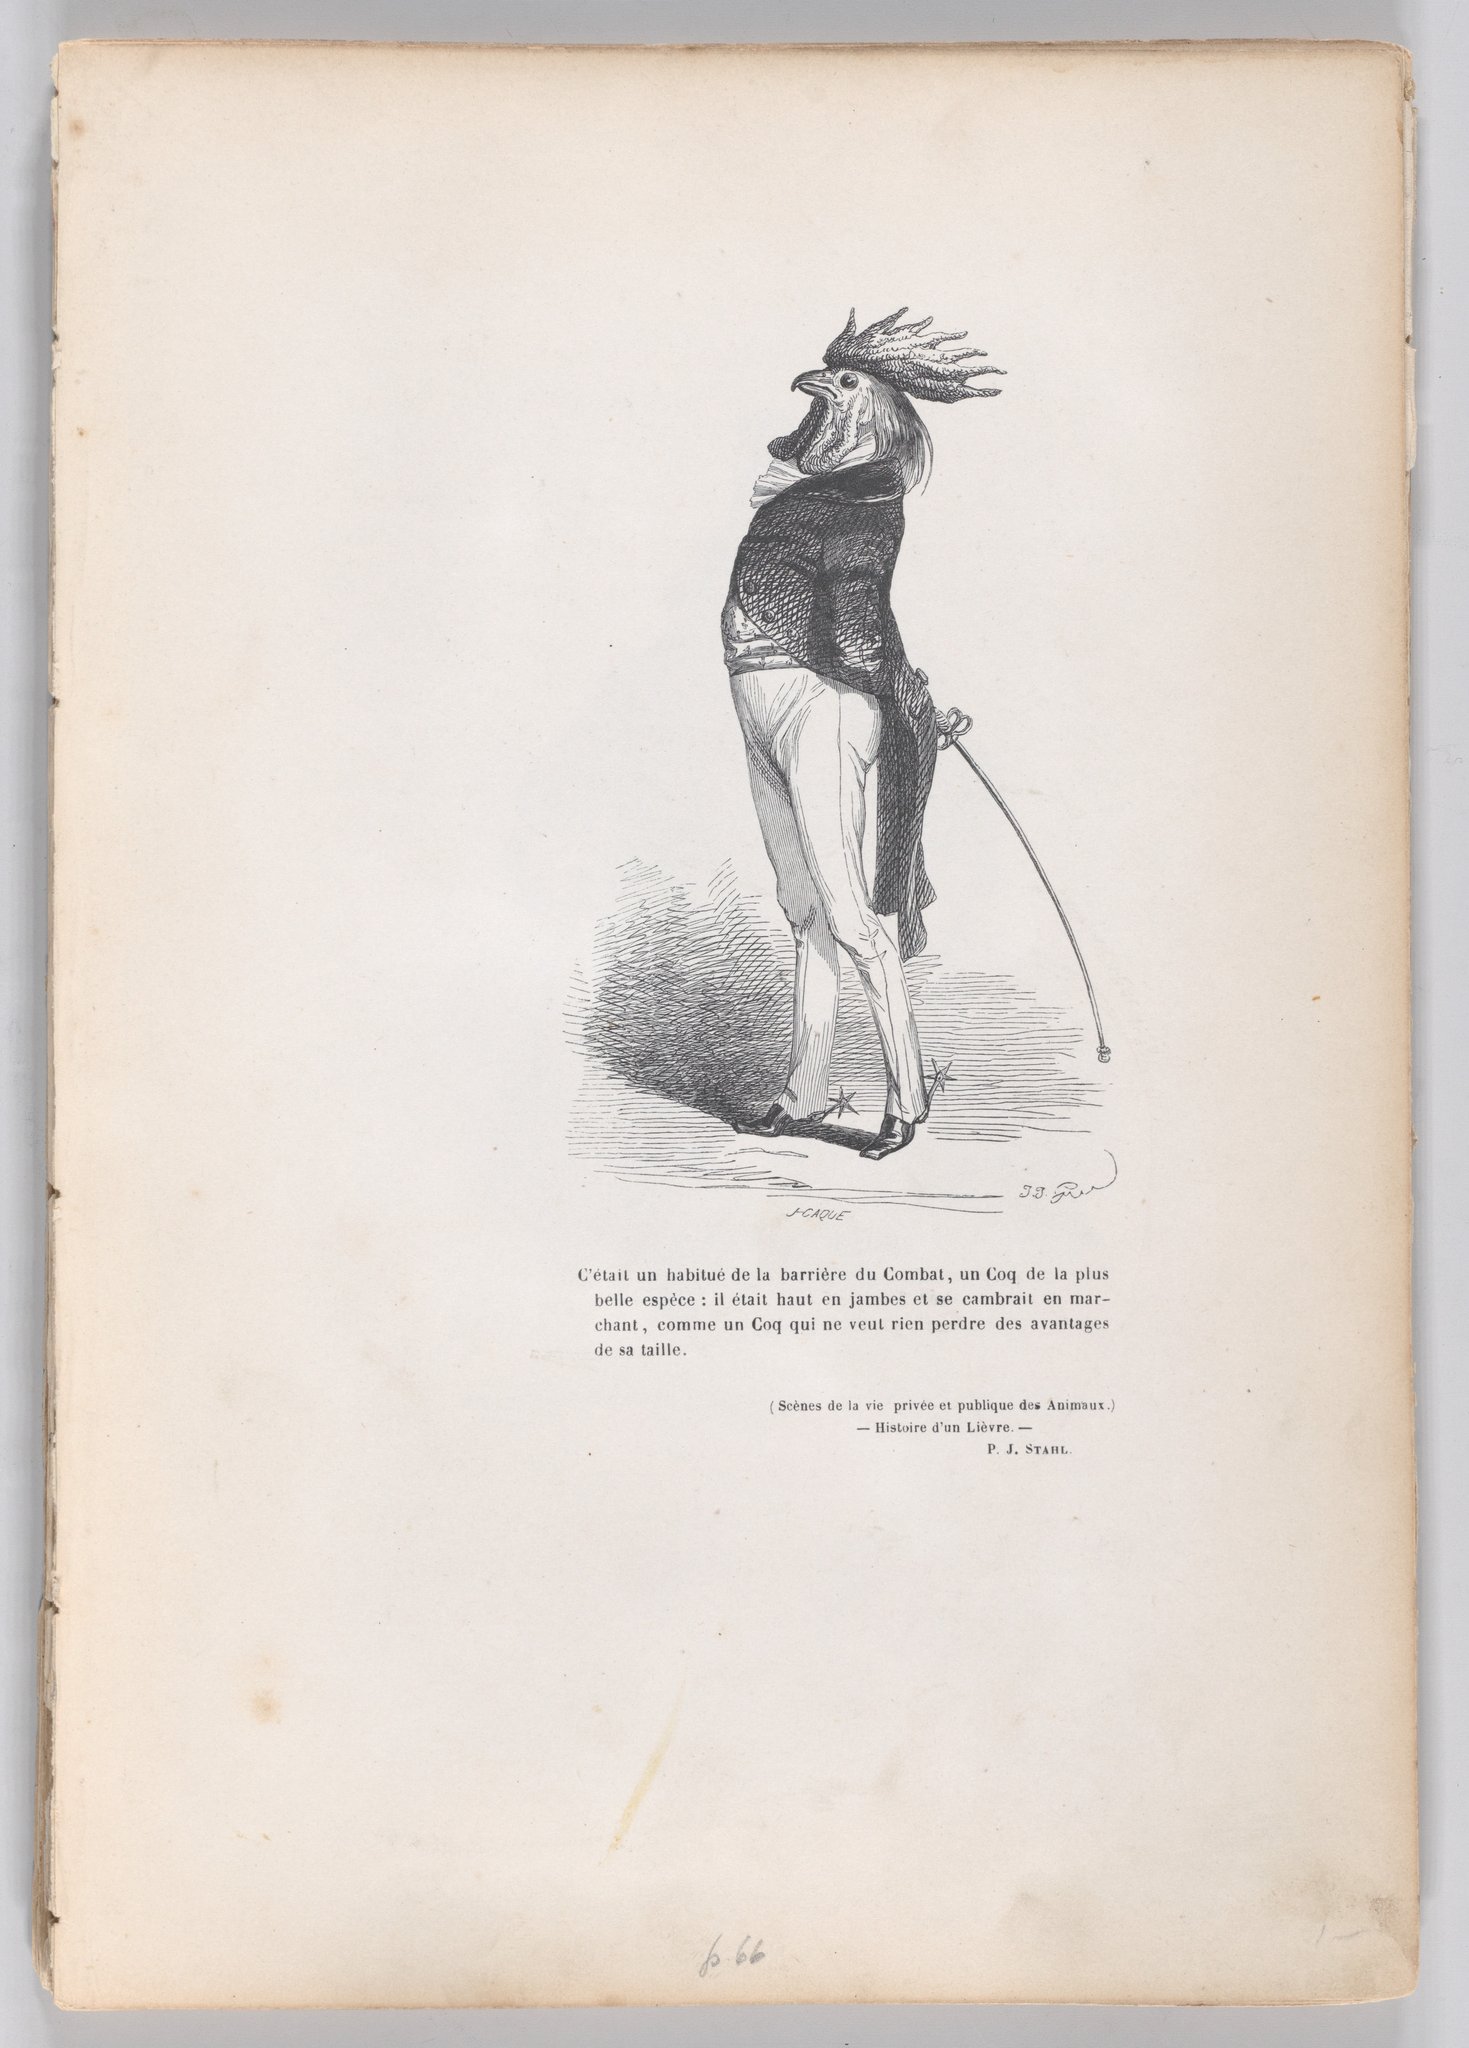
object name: print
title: He was a regular on the front lines..., from "Scenes from the Private and Public Life of Animals"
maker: j. j. grandville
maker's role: illustrator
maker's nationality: french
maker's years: 1803-1847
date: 1837-1847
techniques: engraving